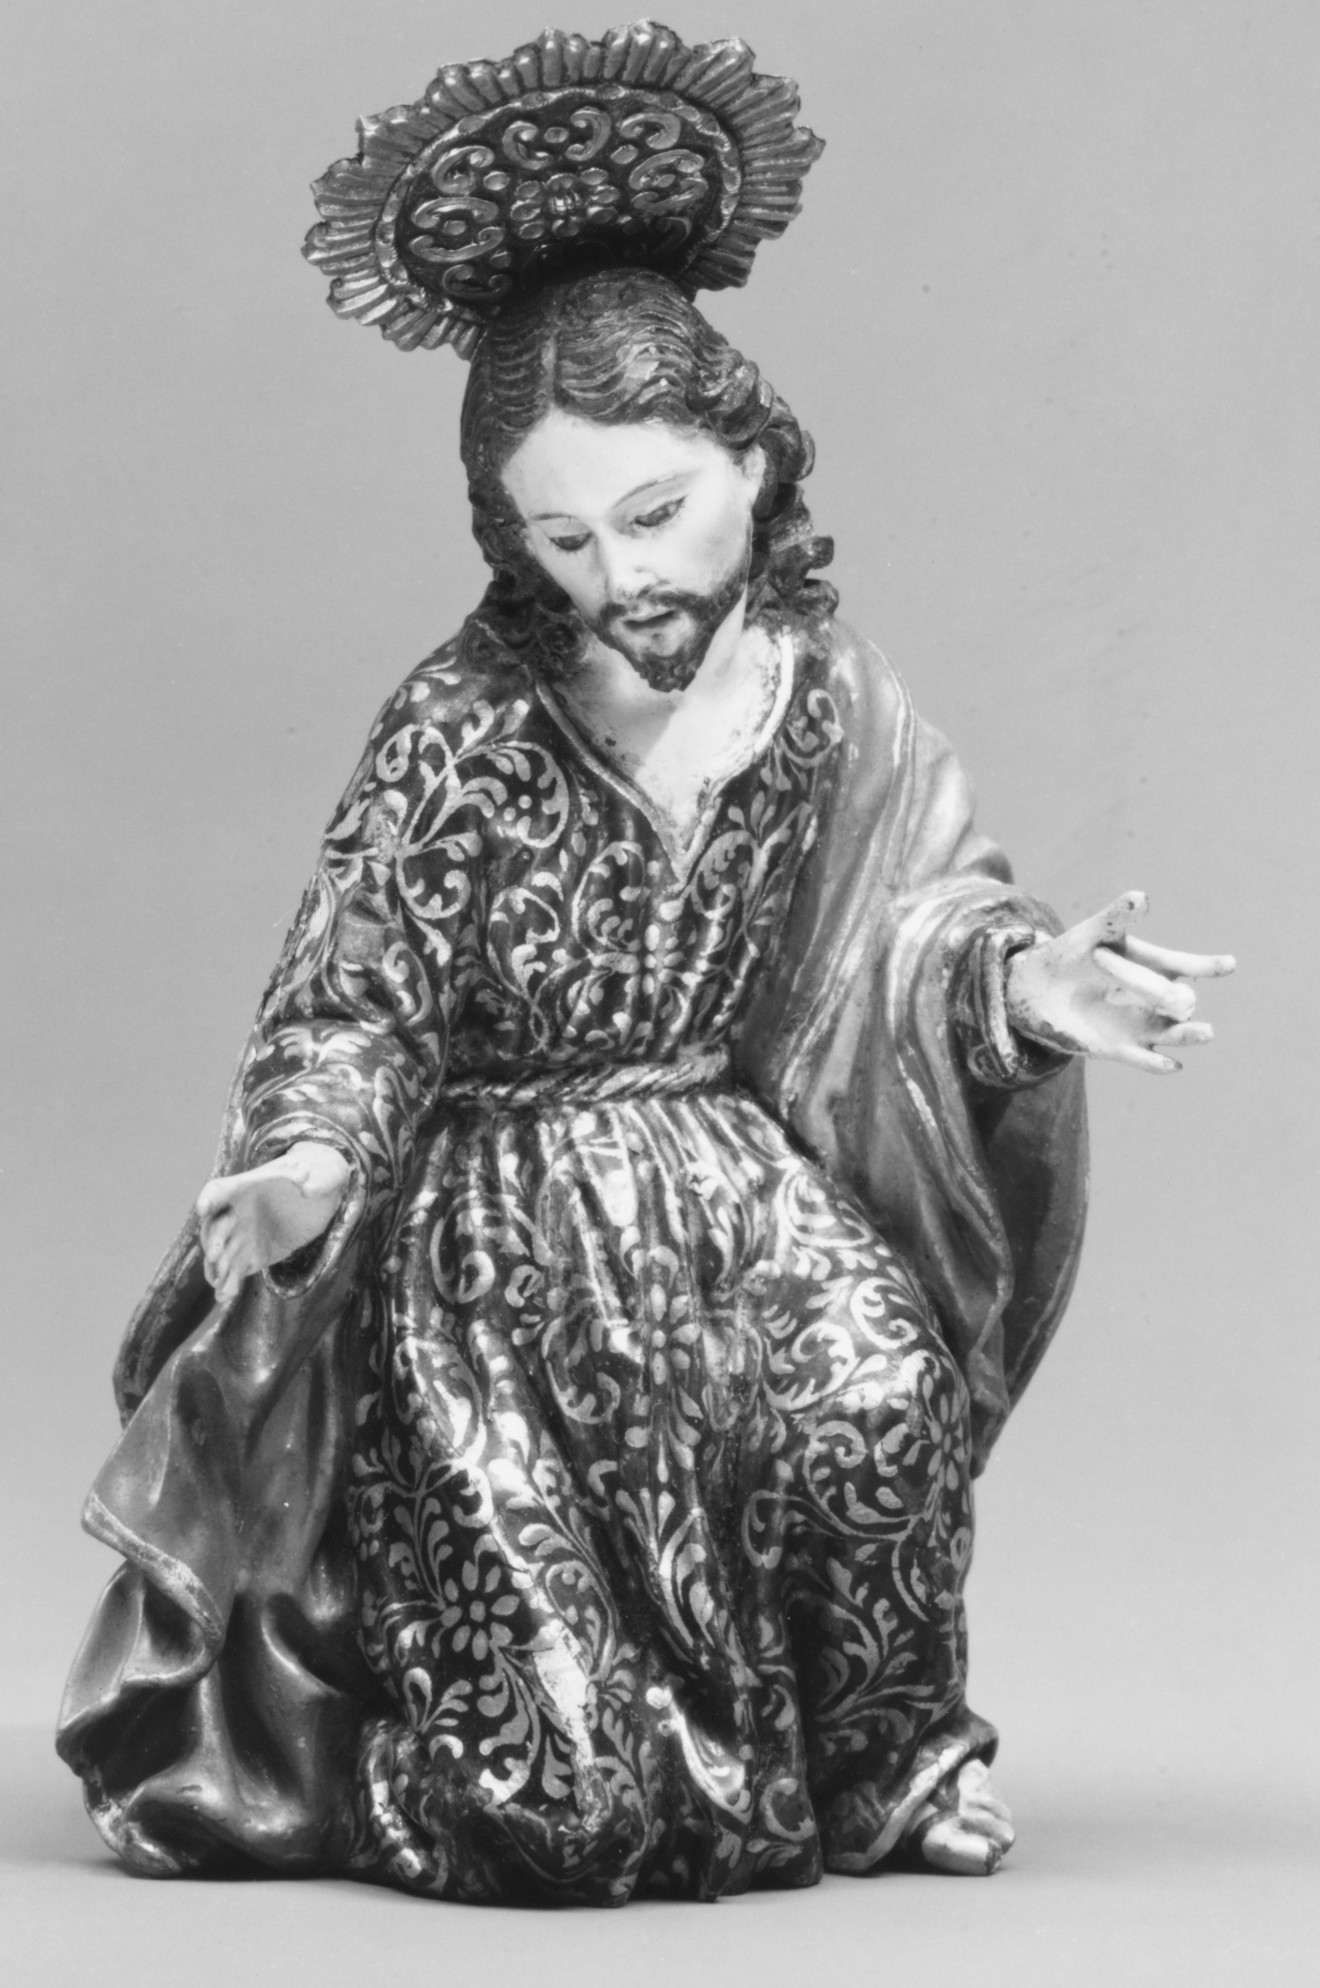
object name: statuette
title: Joseph (from a nativity)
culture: ecuadorian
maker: caspicara (manuel chil)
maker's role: former attribution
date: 1701-1800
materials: glass, metal, wood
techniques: gilding, polychrome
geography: ecuador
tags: men